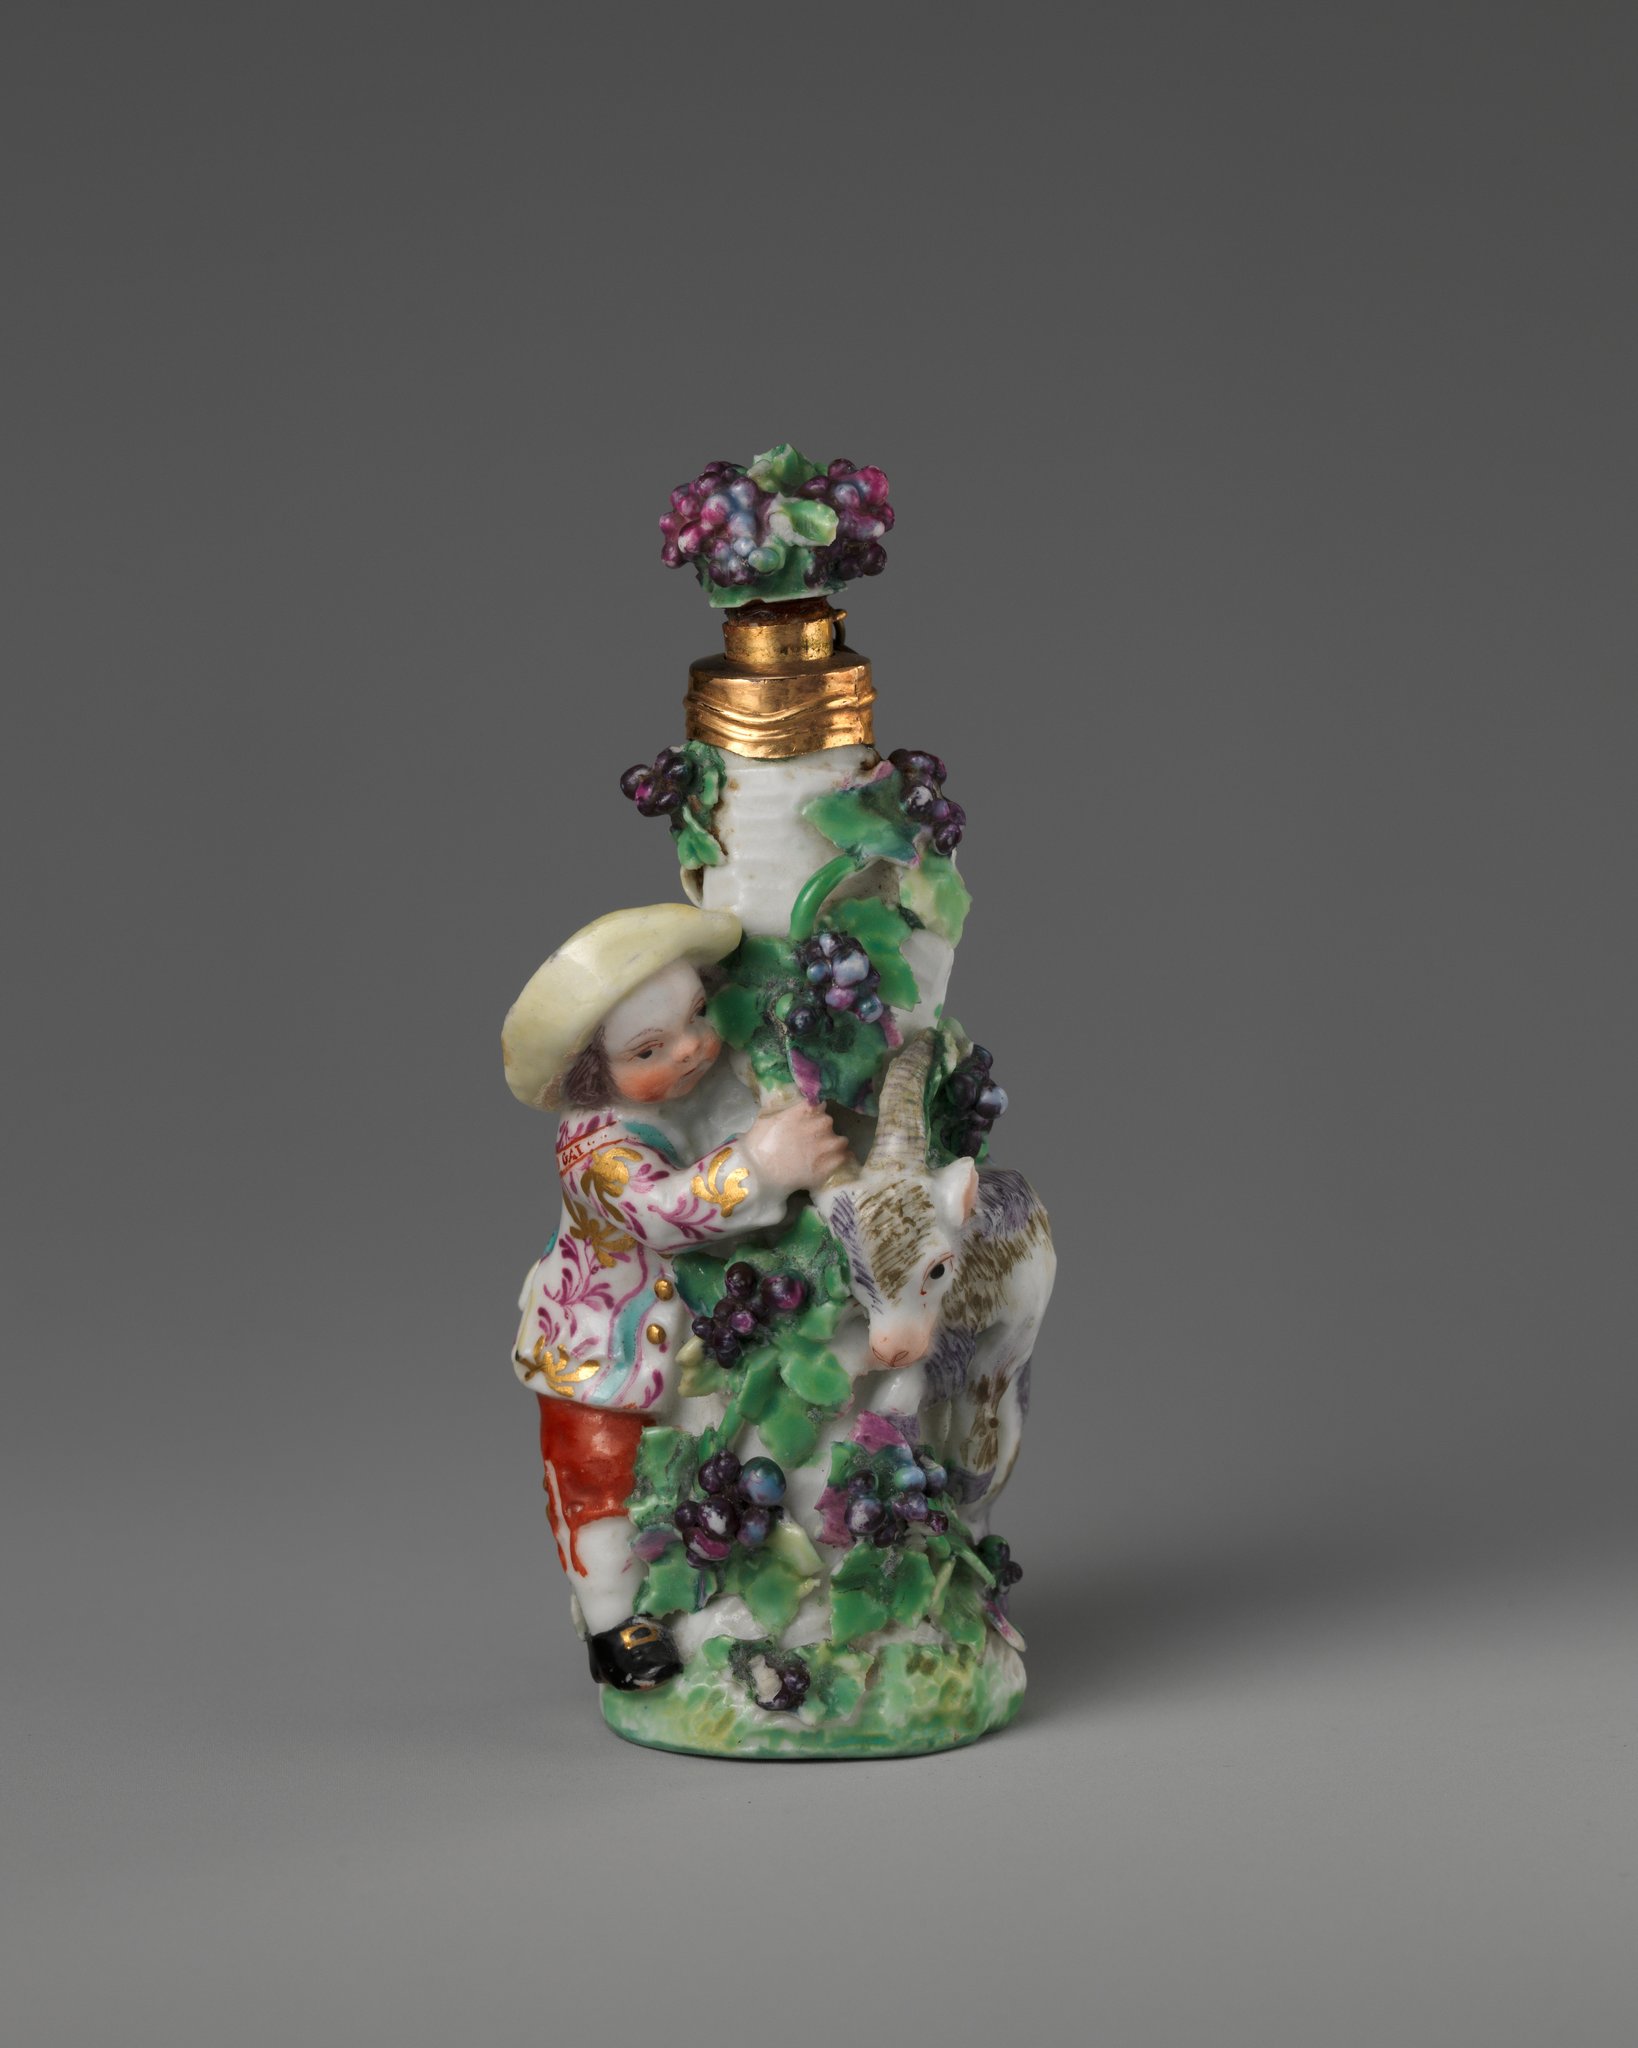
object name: toy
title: Boy with goat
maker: chelsea porcelain manufactory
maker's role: factory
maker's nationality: british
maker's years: 1744-1784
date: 1765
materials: soft paste porcelain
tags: grapes,boys,goats,leaves